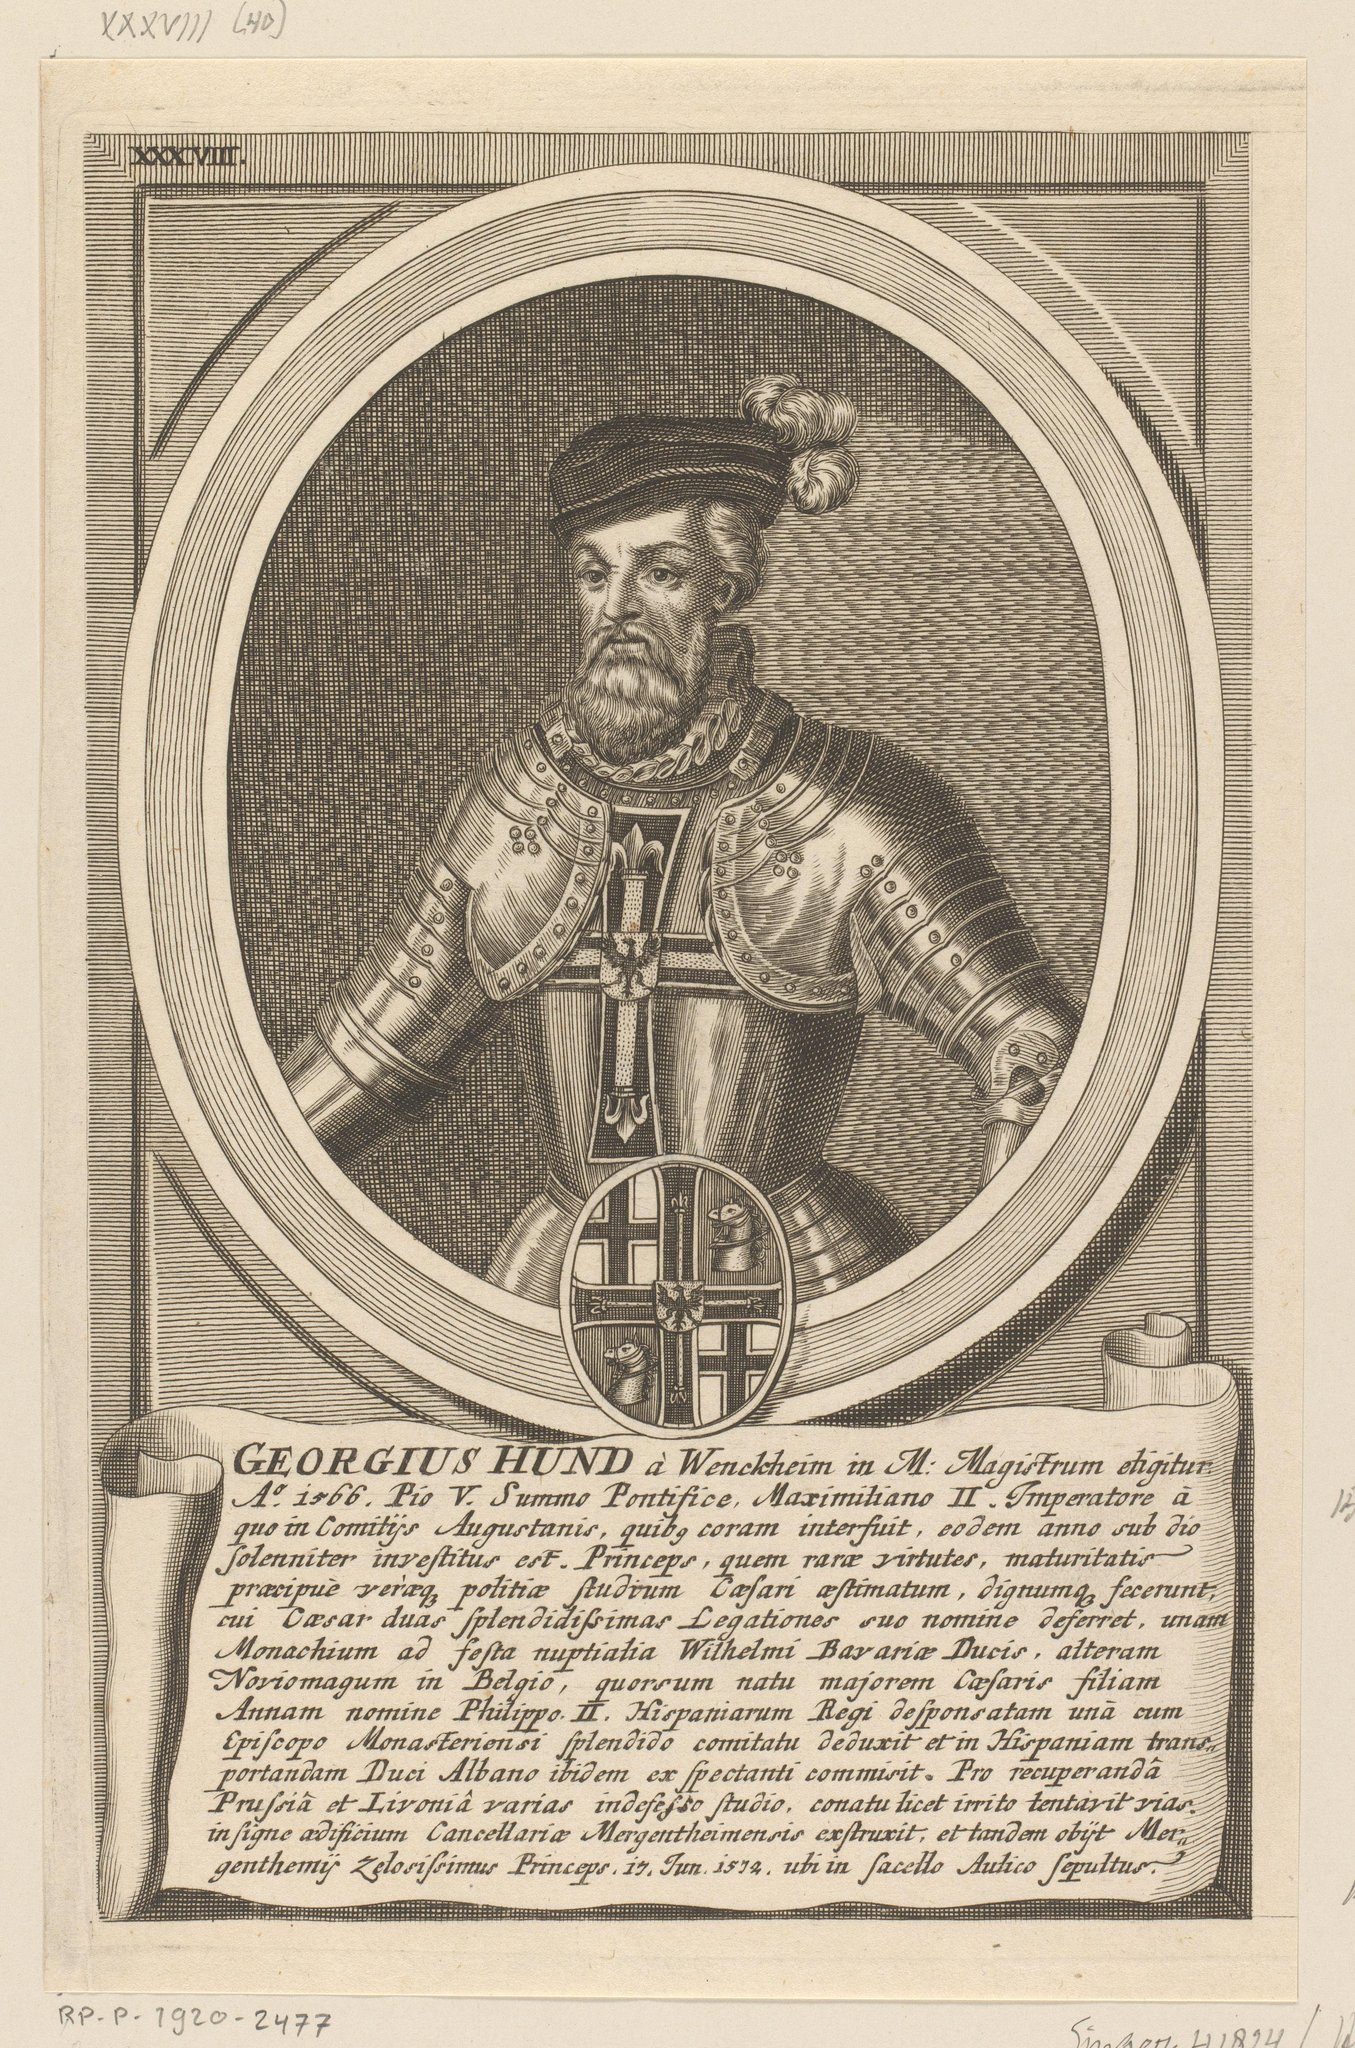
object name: book illustration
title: Portret van Georg Hund von Wenkheim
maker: johann salver (i)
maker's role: print maker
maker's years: 1670-1738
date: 1720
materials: paper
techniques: engraving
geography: würzburg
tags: bad mergentheim, knighthood order: teutonic order - insignia of a knighthood order, e.g.: badge, chain (with name of order), armour, historical persons, armorial bearing, heraldry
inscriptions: collector's mark: Lugt 2228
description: Prent uit: [Salver, Johann]. De origine, secundis et adversis successibus, nec non de statu moderno inclyti ordinis equestris hospitalis b.m.v. Teutonicorum in Jerusalem. Würzburg: Johann Salver, [ca. 1720].